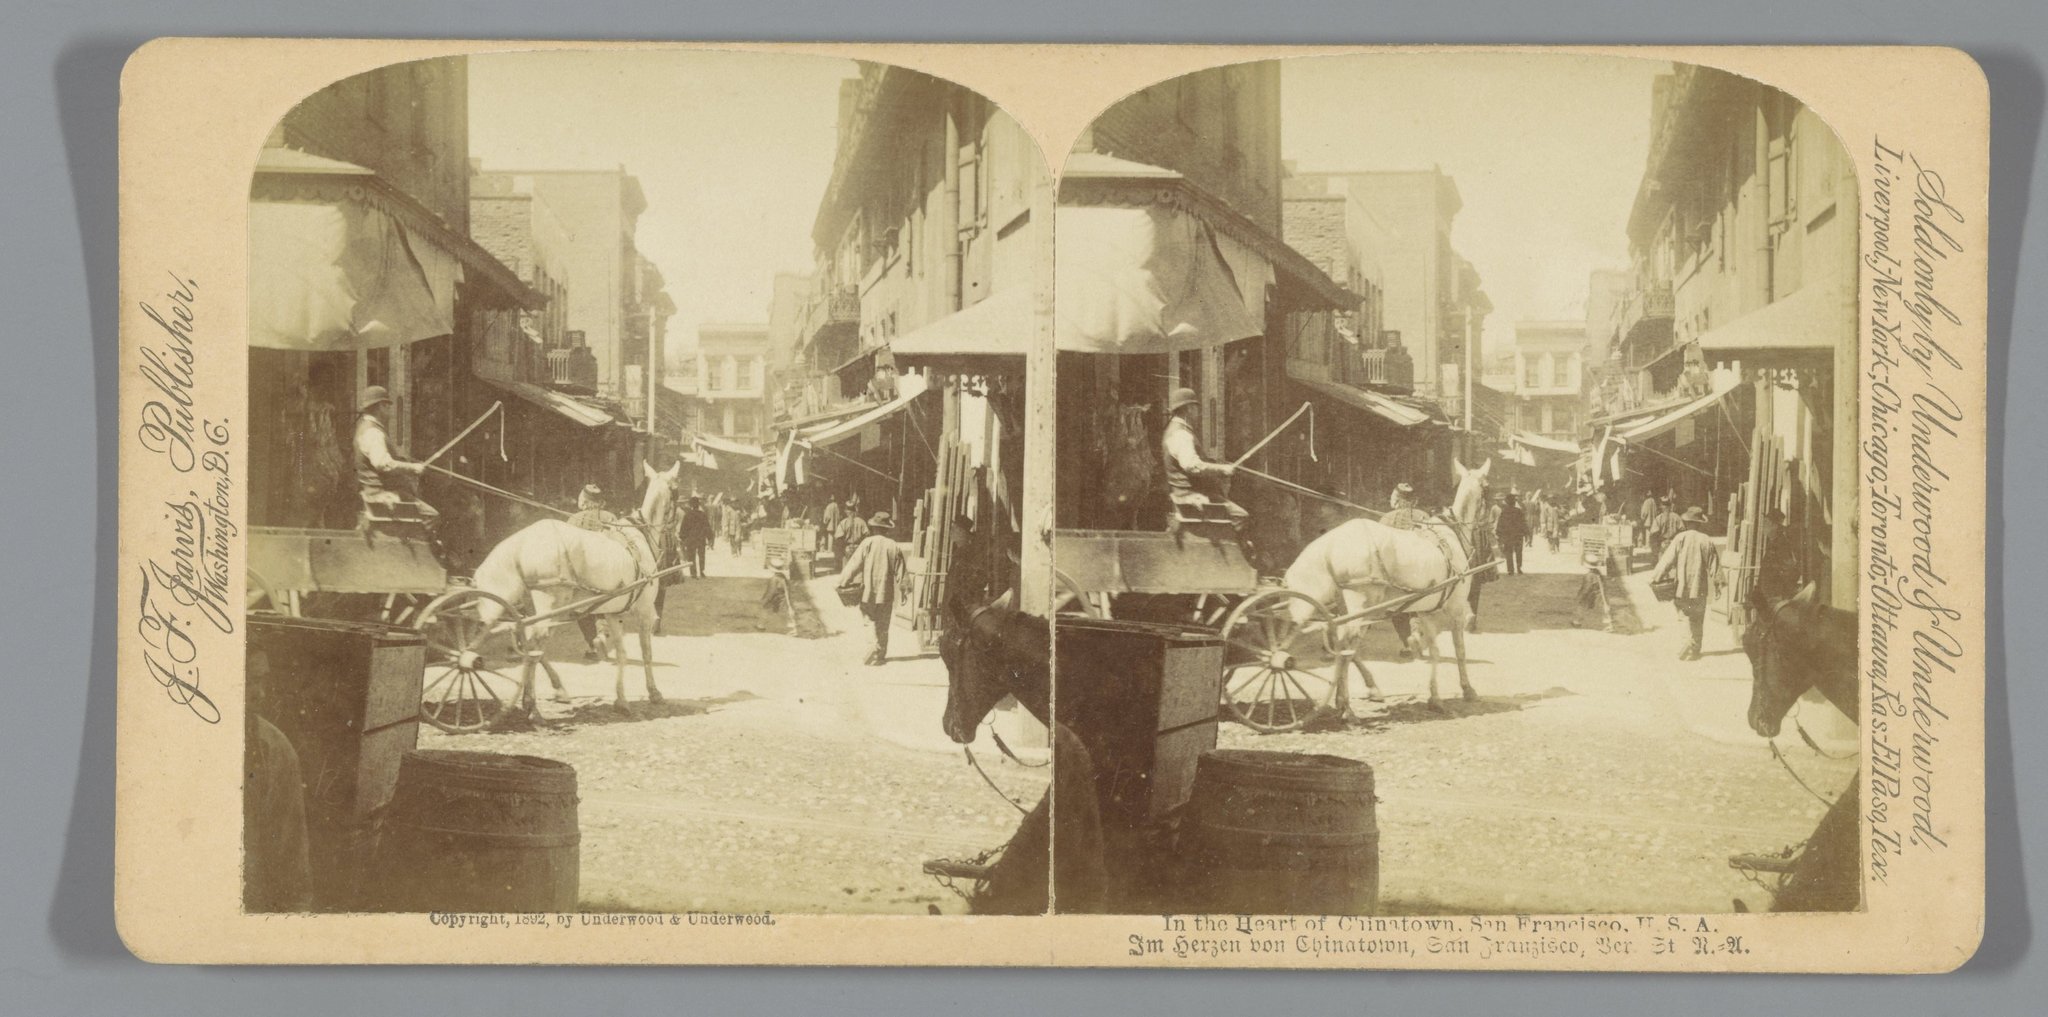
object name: stereograph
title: Een straat in Chinatown, San Francisco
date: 1892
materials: cardboard, paper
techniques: albumen print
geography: washington d.c.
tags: street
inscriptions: number: ‘42’, copyright notice: ‘Copyright, 1892, by Underwood & Underwood.’